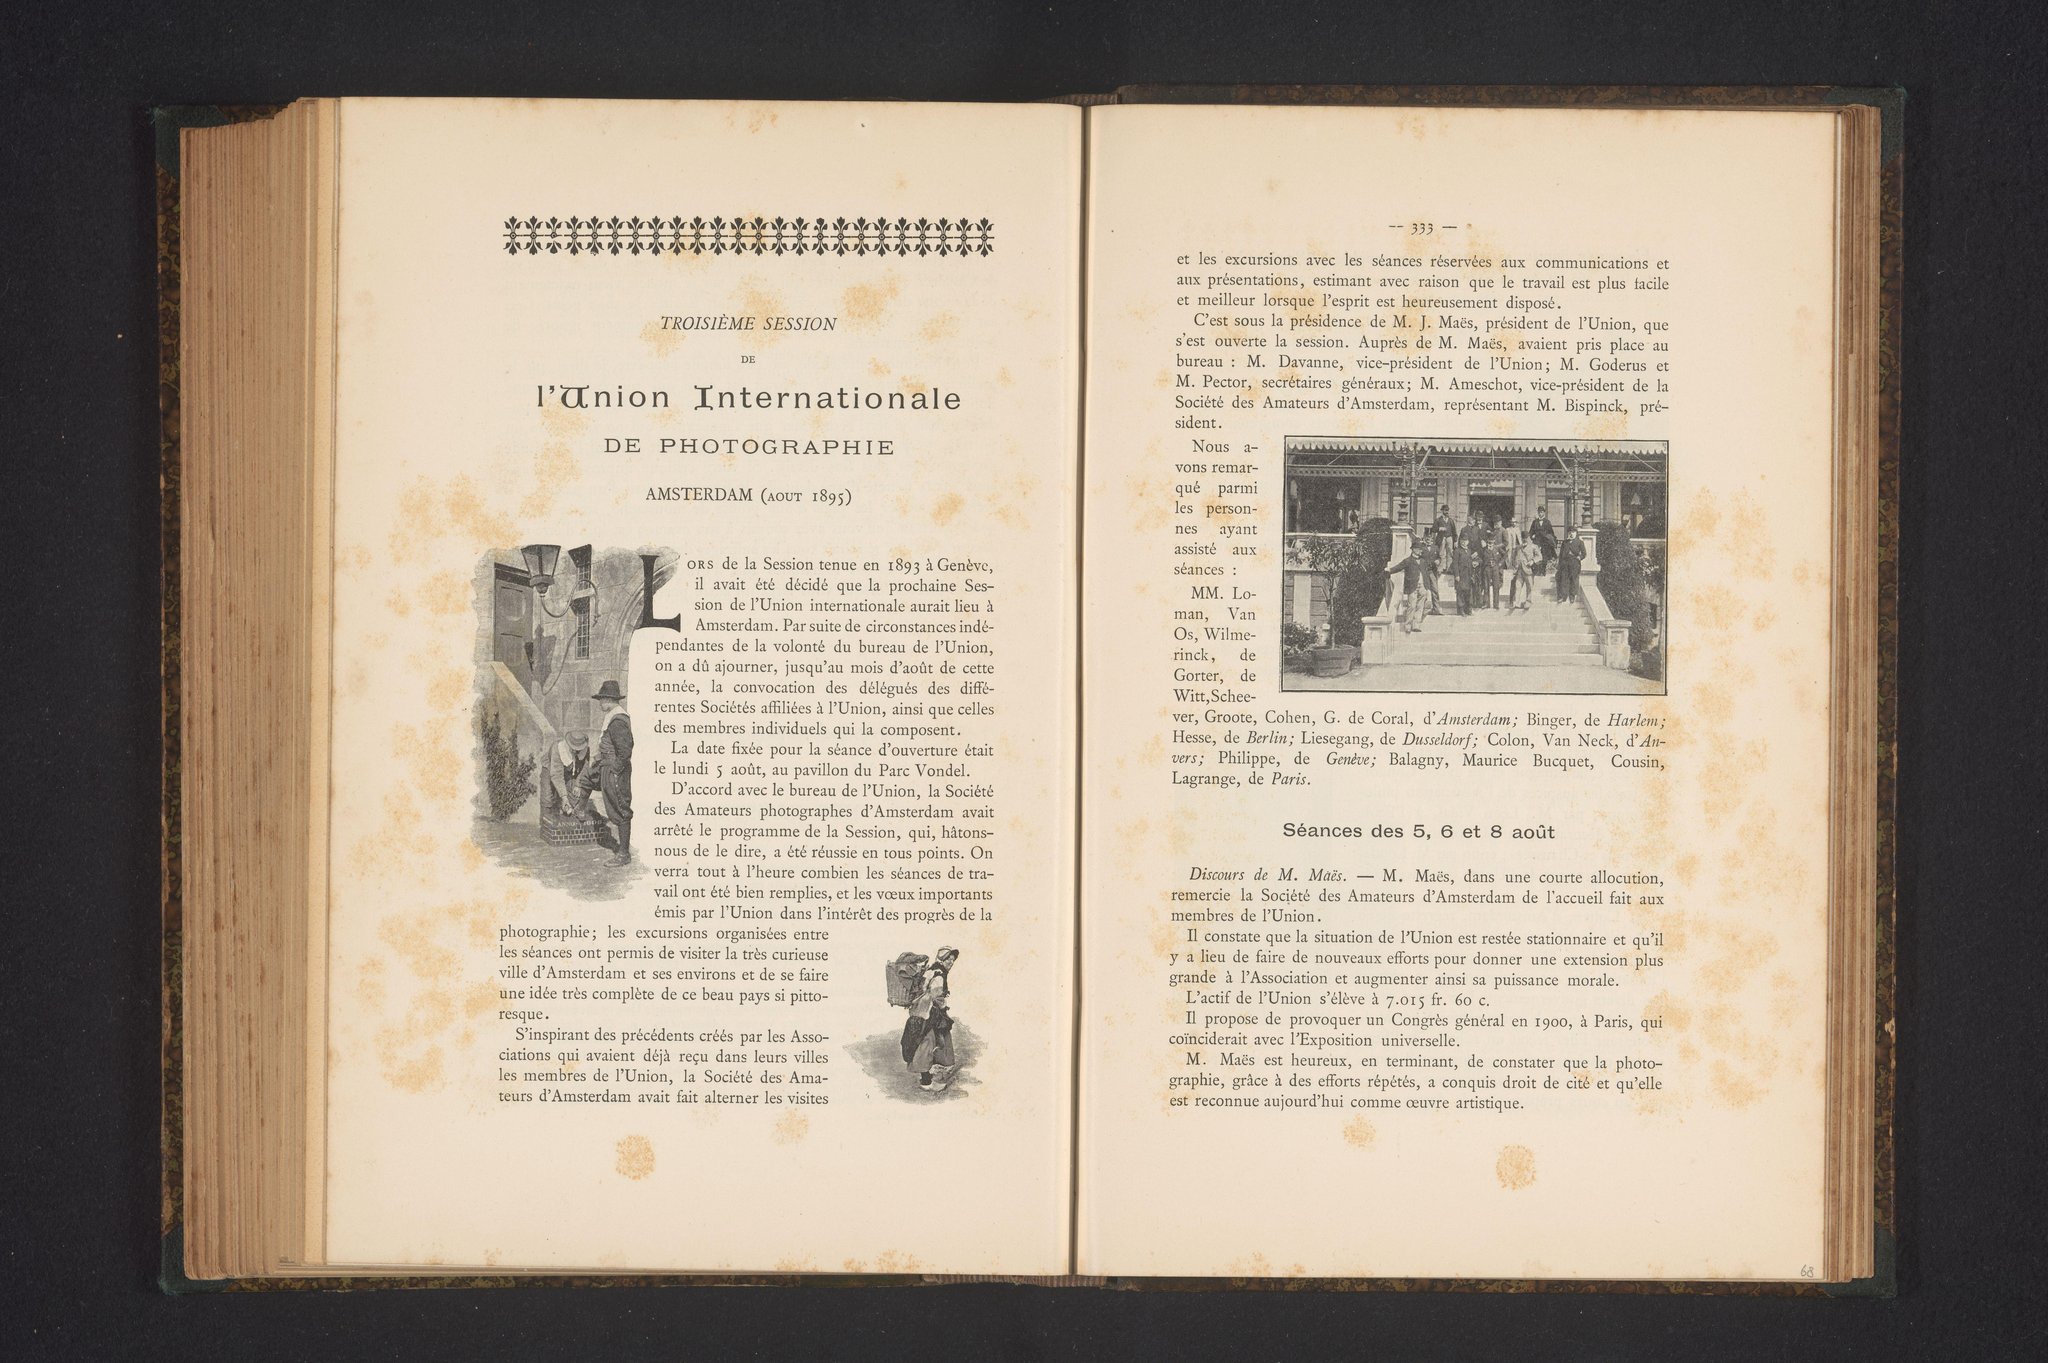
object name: photomechanical print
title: Vissersvrouw in Zandvoort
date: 1890-1895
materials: paper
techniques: autotype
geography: zandvoort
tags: adult woman, fisherman